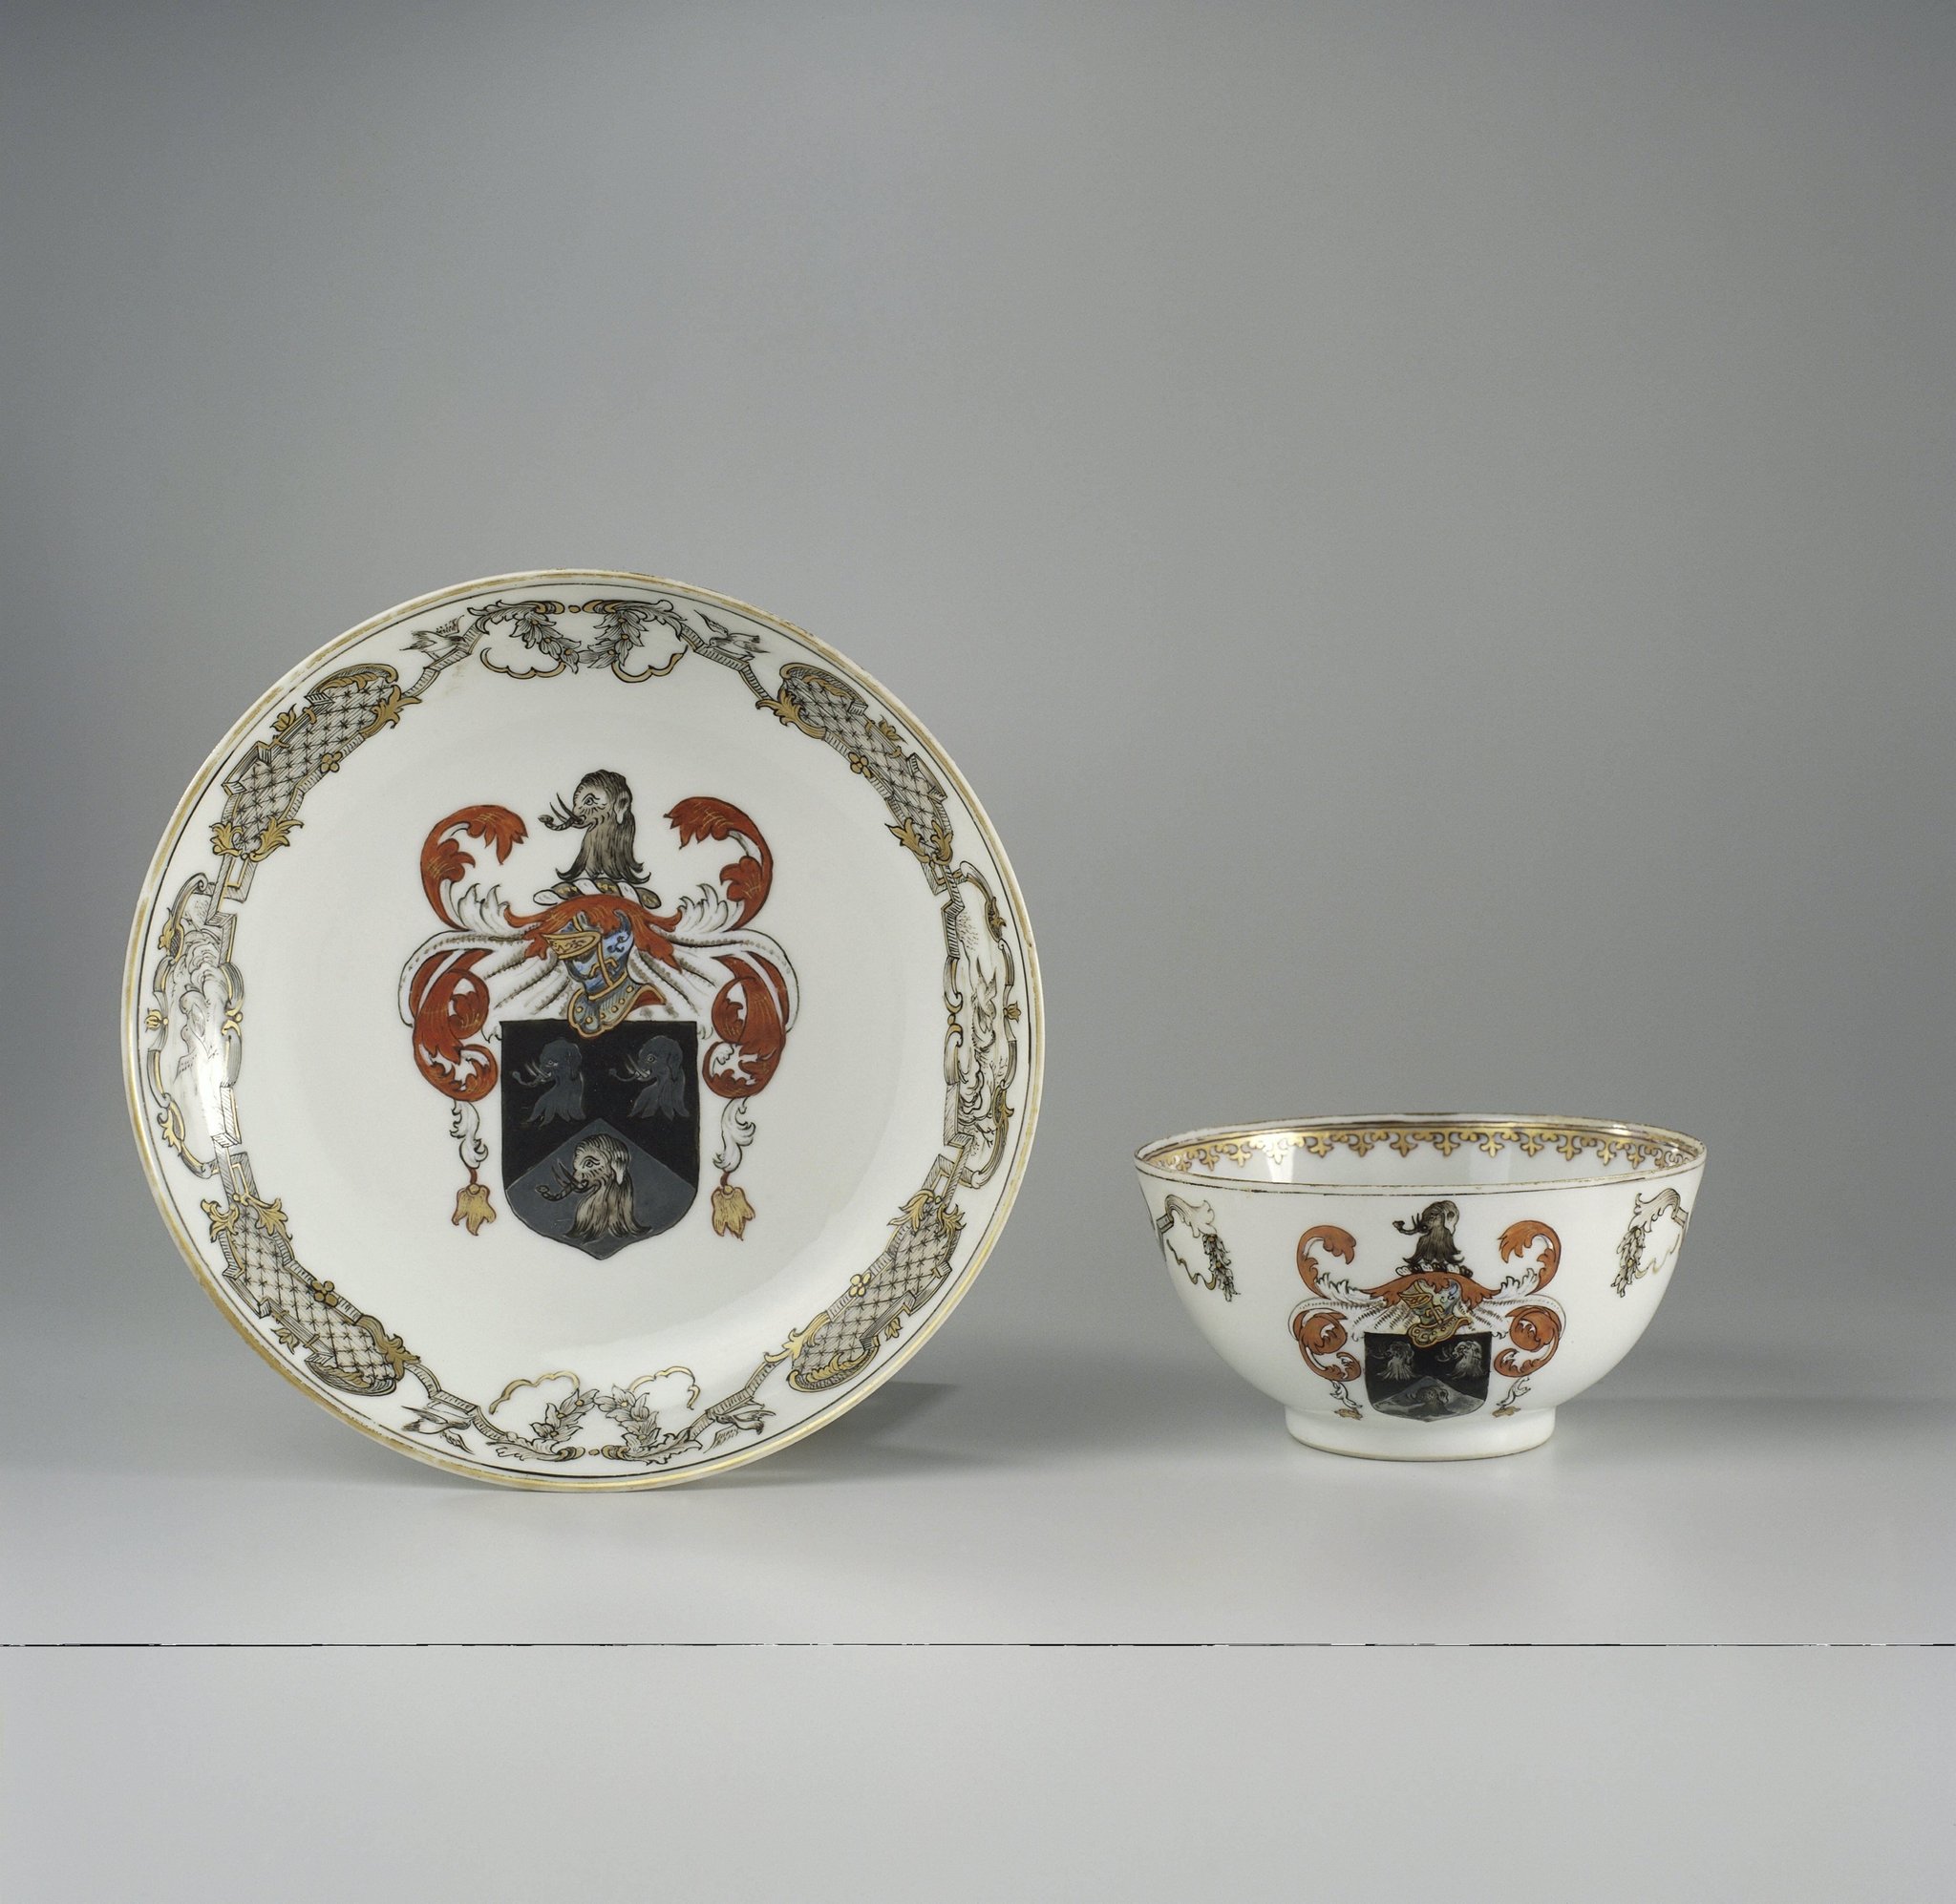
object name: kop en schotel, kop en schotel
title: Cup and saucer with the arms of the Saunders family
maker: Anonymous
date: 1725-1749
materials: glaze, gold, paint, porcelain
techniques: firing, gilding, turning, vitrification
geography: china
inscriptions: label: ‘Saunders (governor of Madras)’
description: Kop en schotel van porselein, beschilderd op het glazuur in blauw, rood, zwart en goud. Op het plat van de schotel het wapen van de familie Saunders met drie olifanten; het helmteken is tevens een olifant omgeven door acanthusbladeren. Op de wand een Europese decoratieve band in Lodewijk XIV-stijl met vogels en servetwerk in cartouches. Oud label op de onderzijde met 'Saunders (governor of Madras)'. Een barst in de wand van de kop. Wapenporselein met emailkleuren.